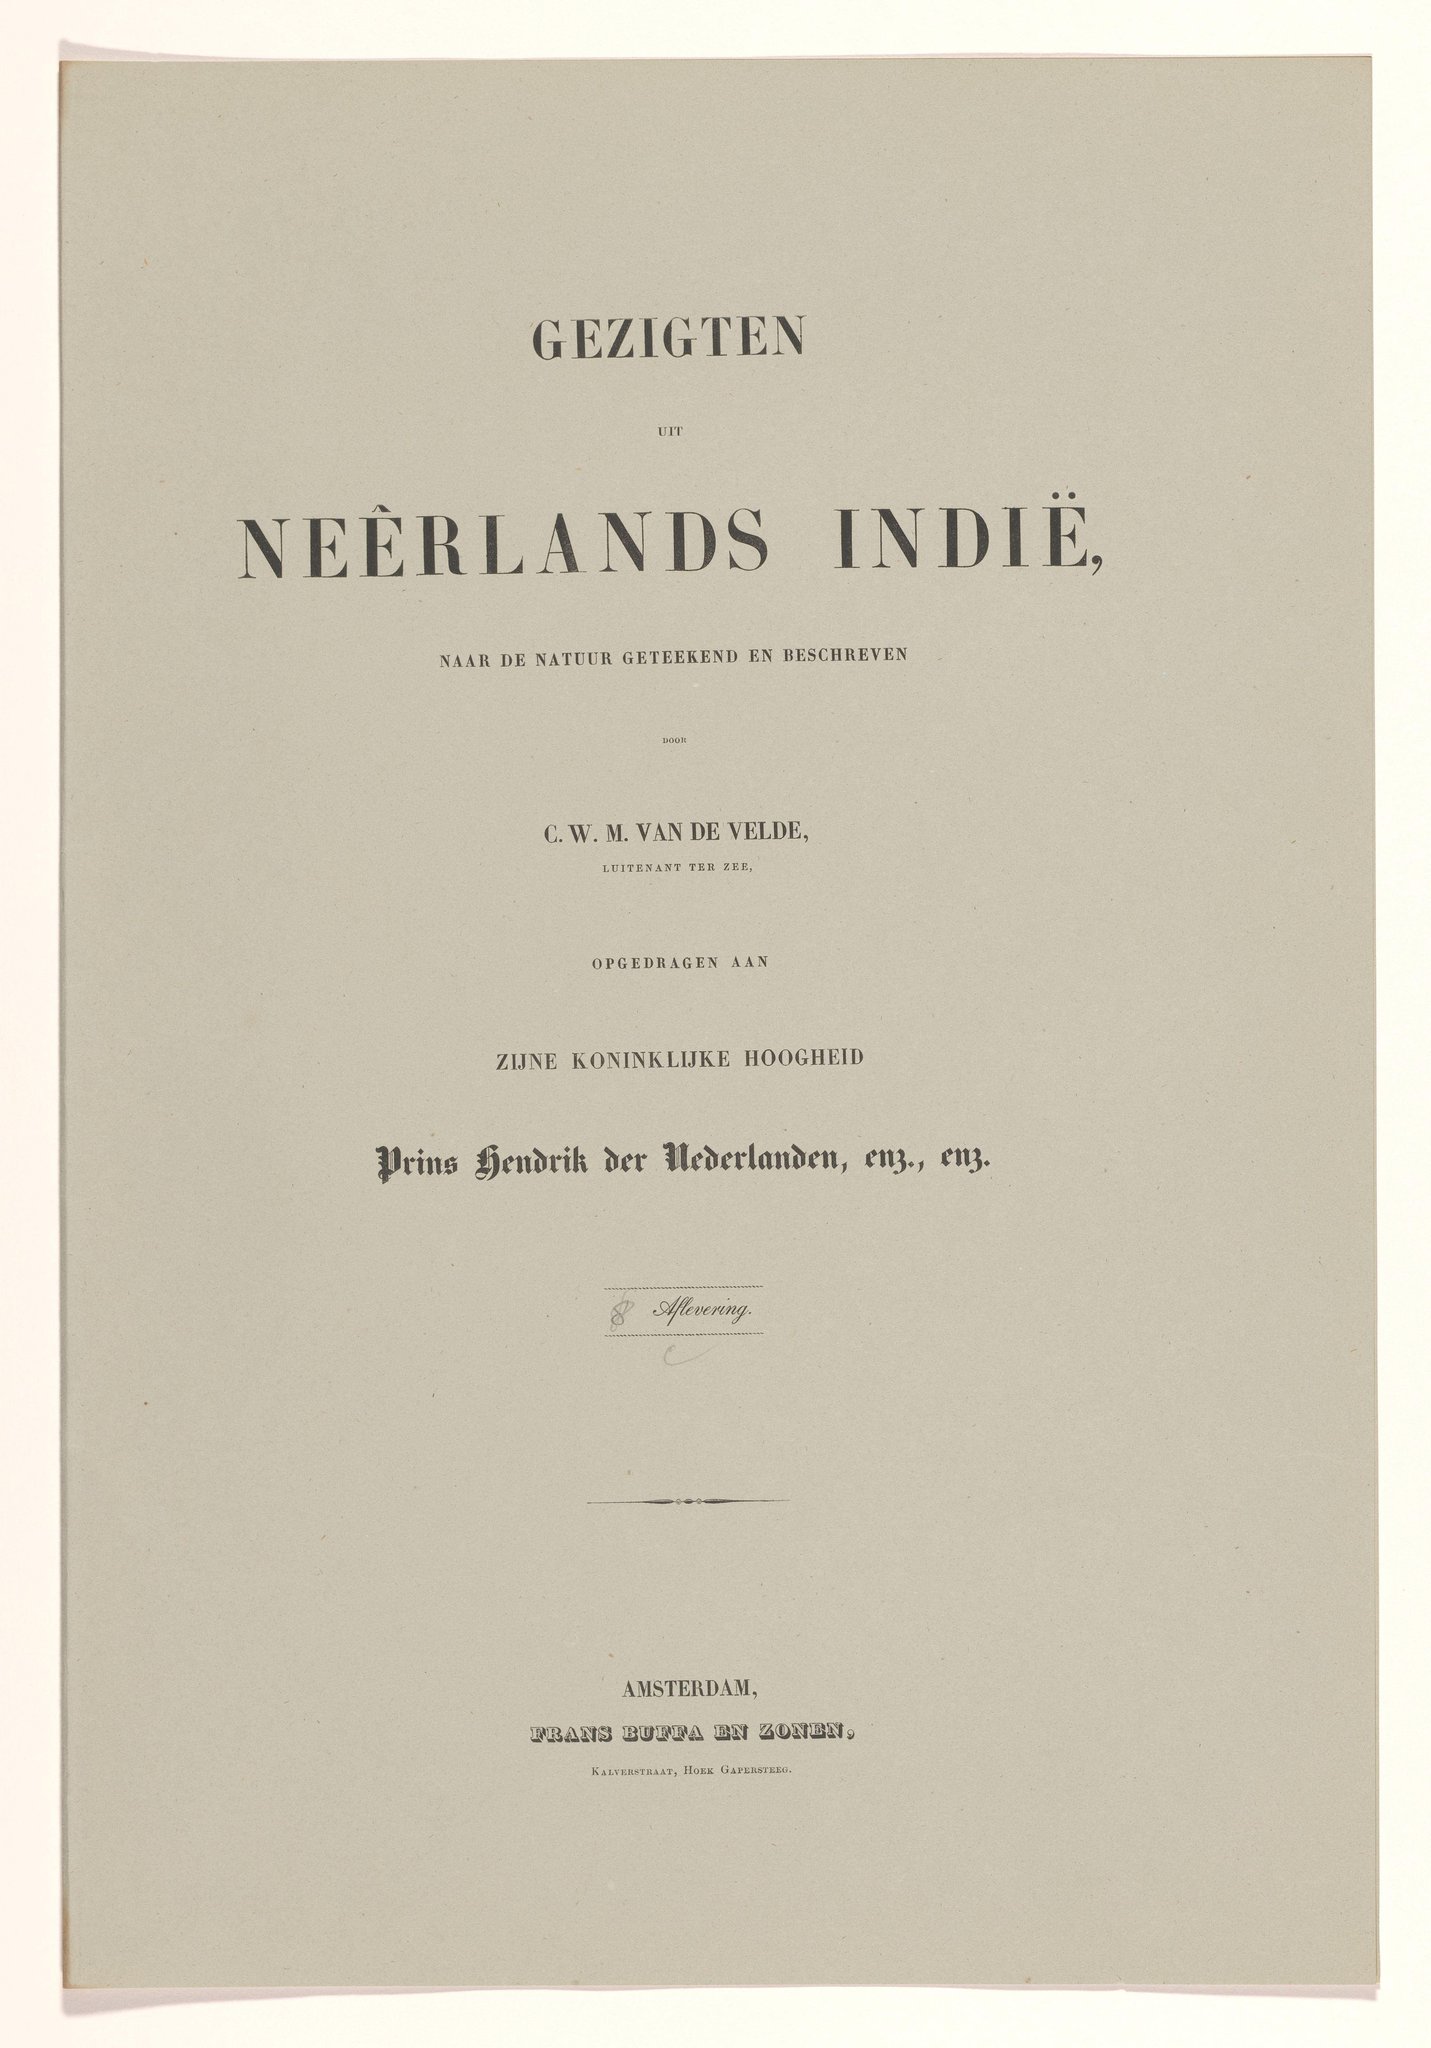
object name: print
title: Omslag met tekstbladen en prenten over Nederlands Indië: achtste aflevering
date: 1843-1845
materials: paper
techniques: lithograph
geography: brussels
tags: landscapes in the non-temperate zone, exotic landscapes, dutch east indies, the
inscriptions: inscription: ‘8 C’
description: Omslag met acht losse bladen waaronder twee tekstbladen en zes lithografieën. De omslag maakt deel uit van een map met twaalf omslagen.